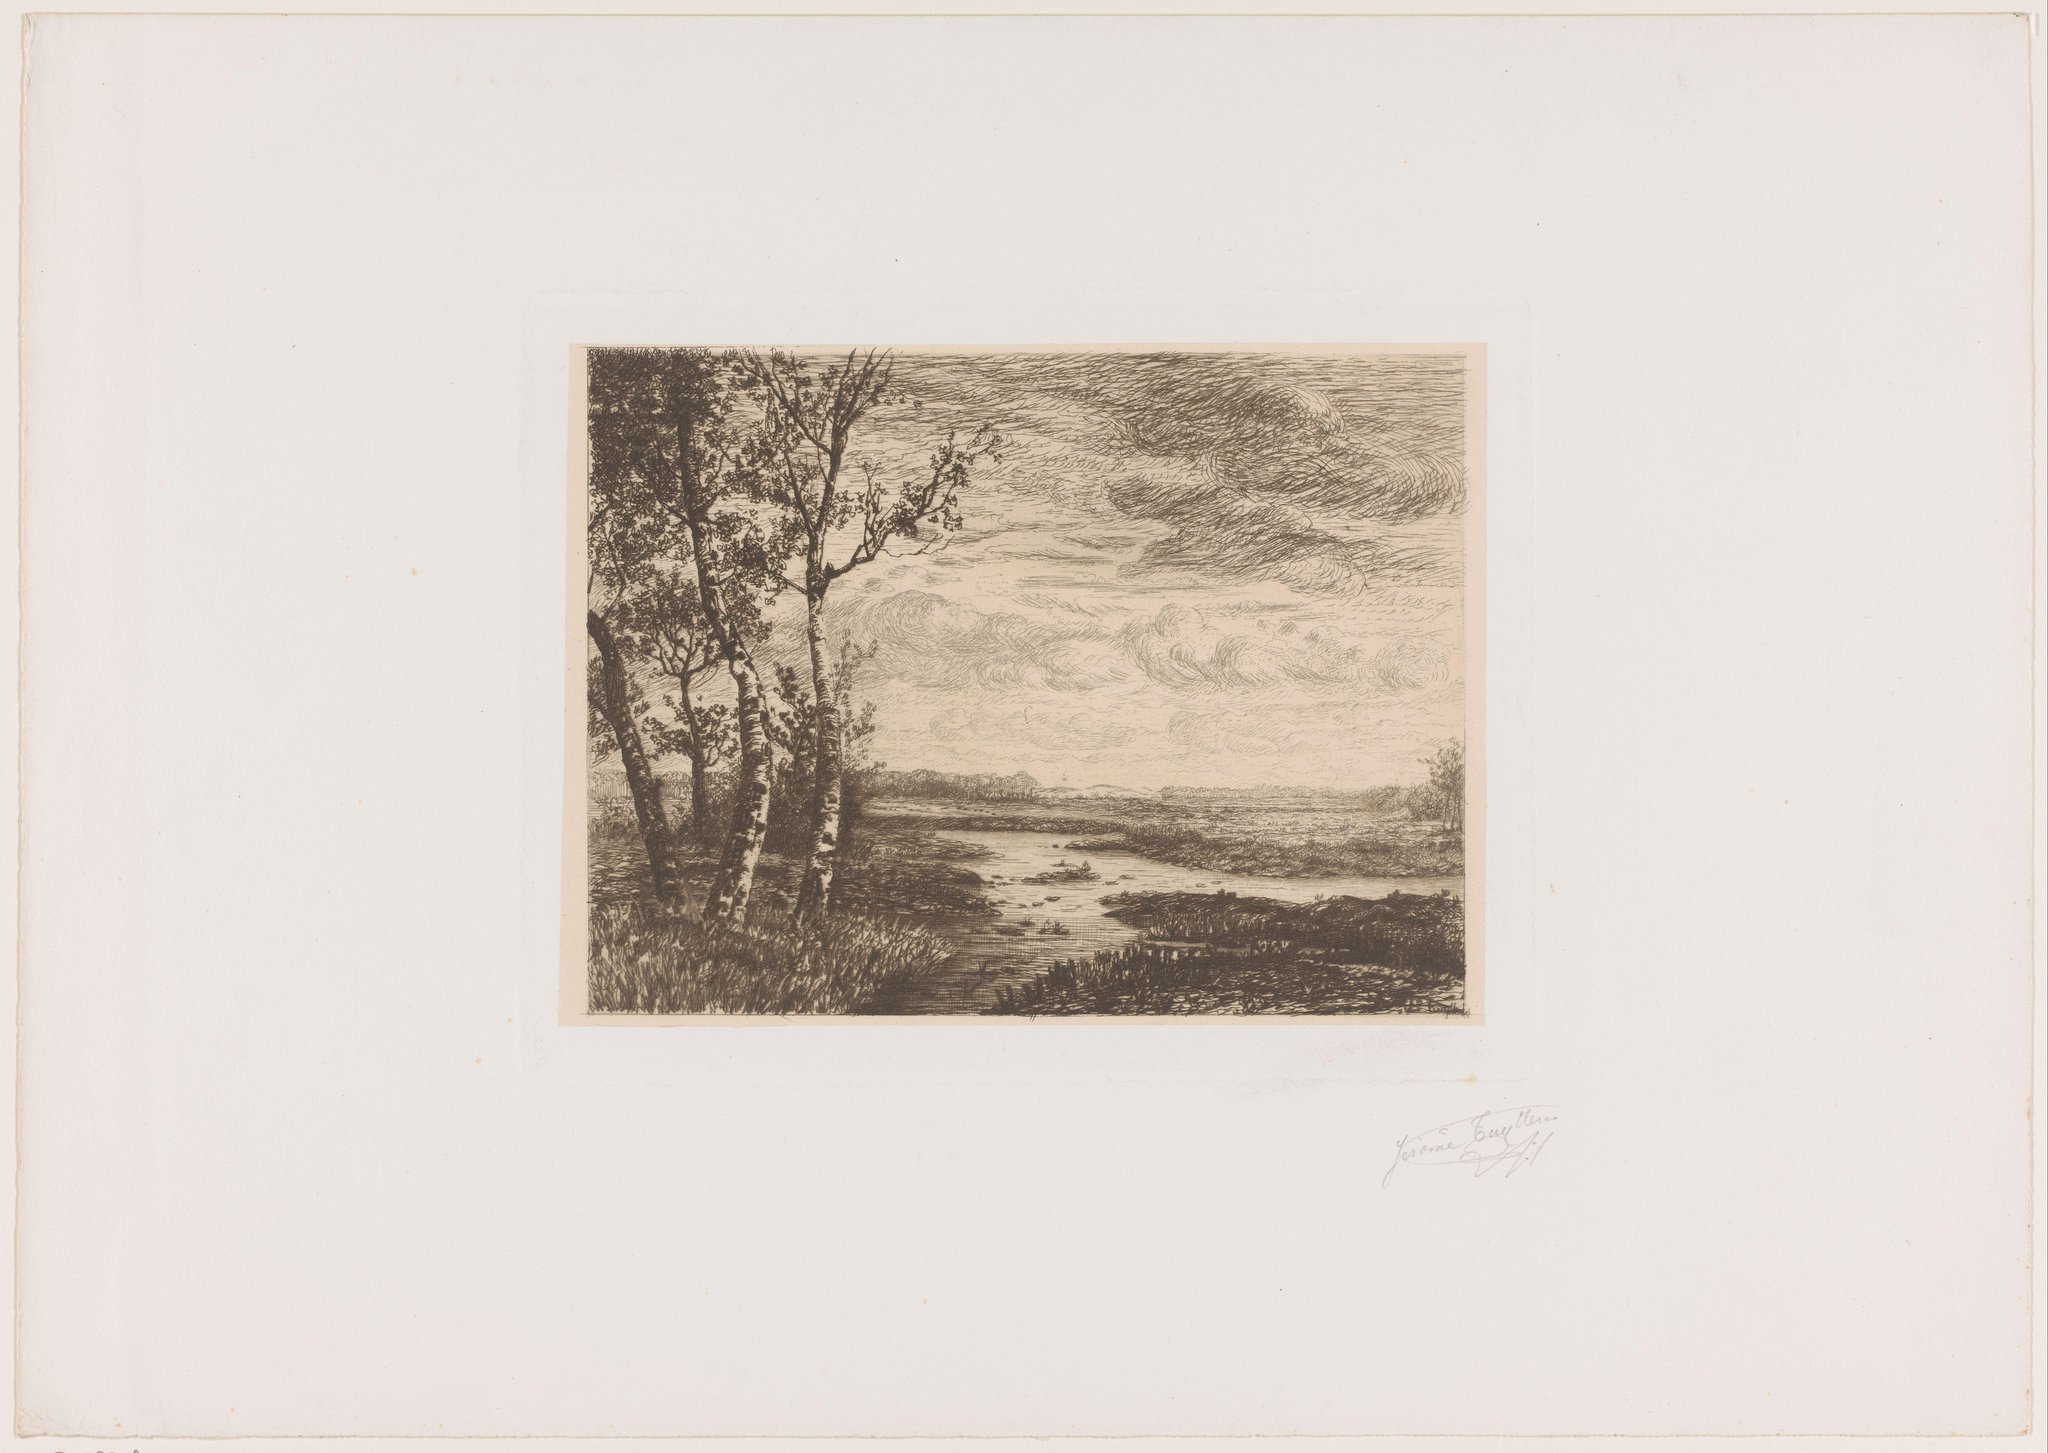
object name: print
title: Landschap met drie berken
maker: jerôme tuyttens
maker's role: painter, print maker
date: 1850-1883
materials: paper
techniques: drypoint, etching, intaglio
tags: water course, trees: birch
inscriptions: collector's mark: Lugt 2228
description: Sterfdatum van de prentmaker is onbekend. Daarom is voor de bepaling van de rechten van dit object gebruik gemaakt van de verwervingsdatum Rijksmuseum Amsterdam.